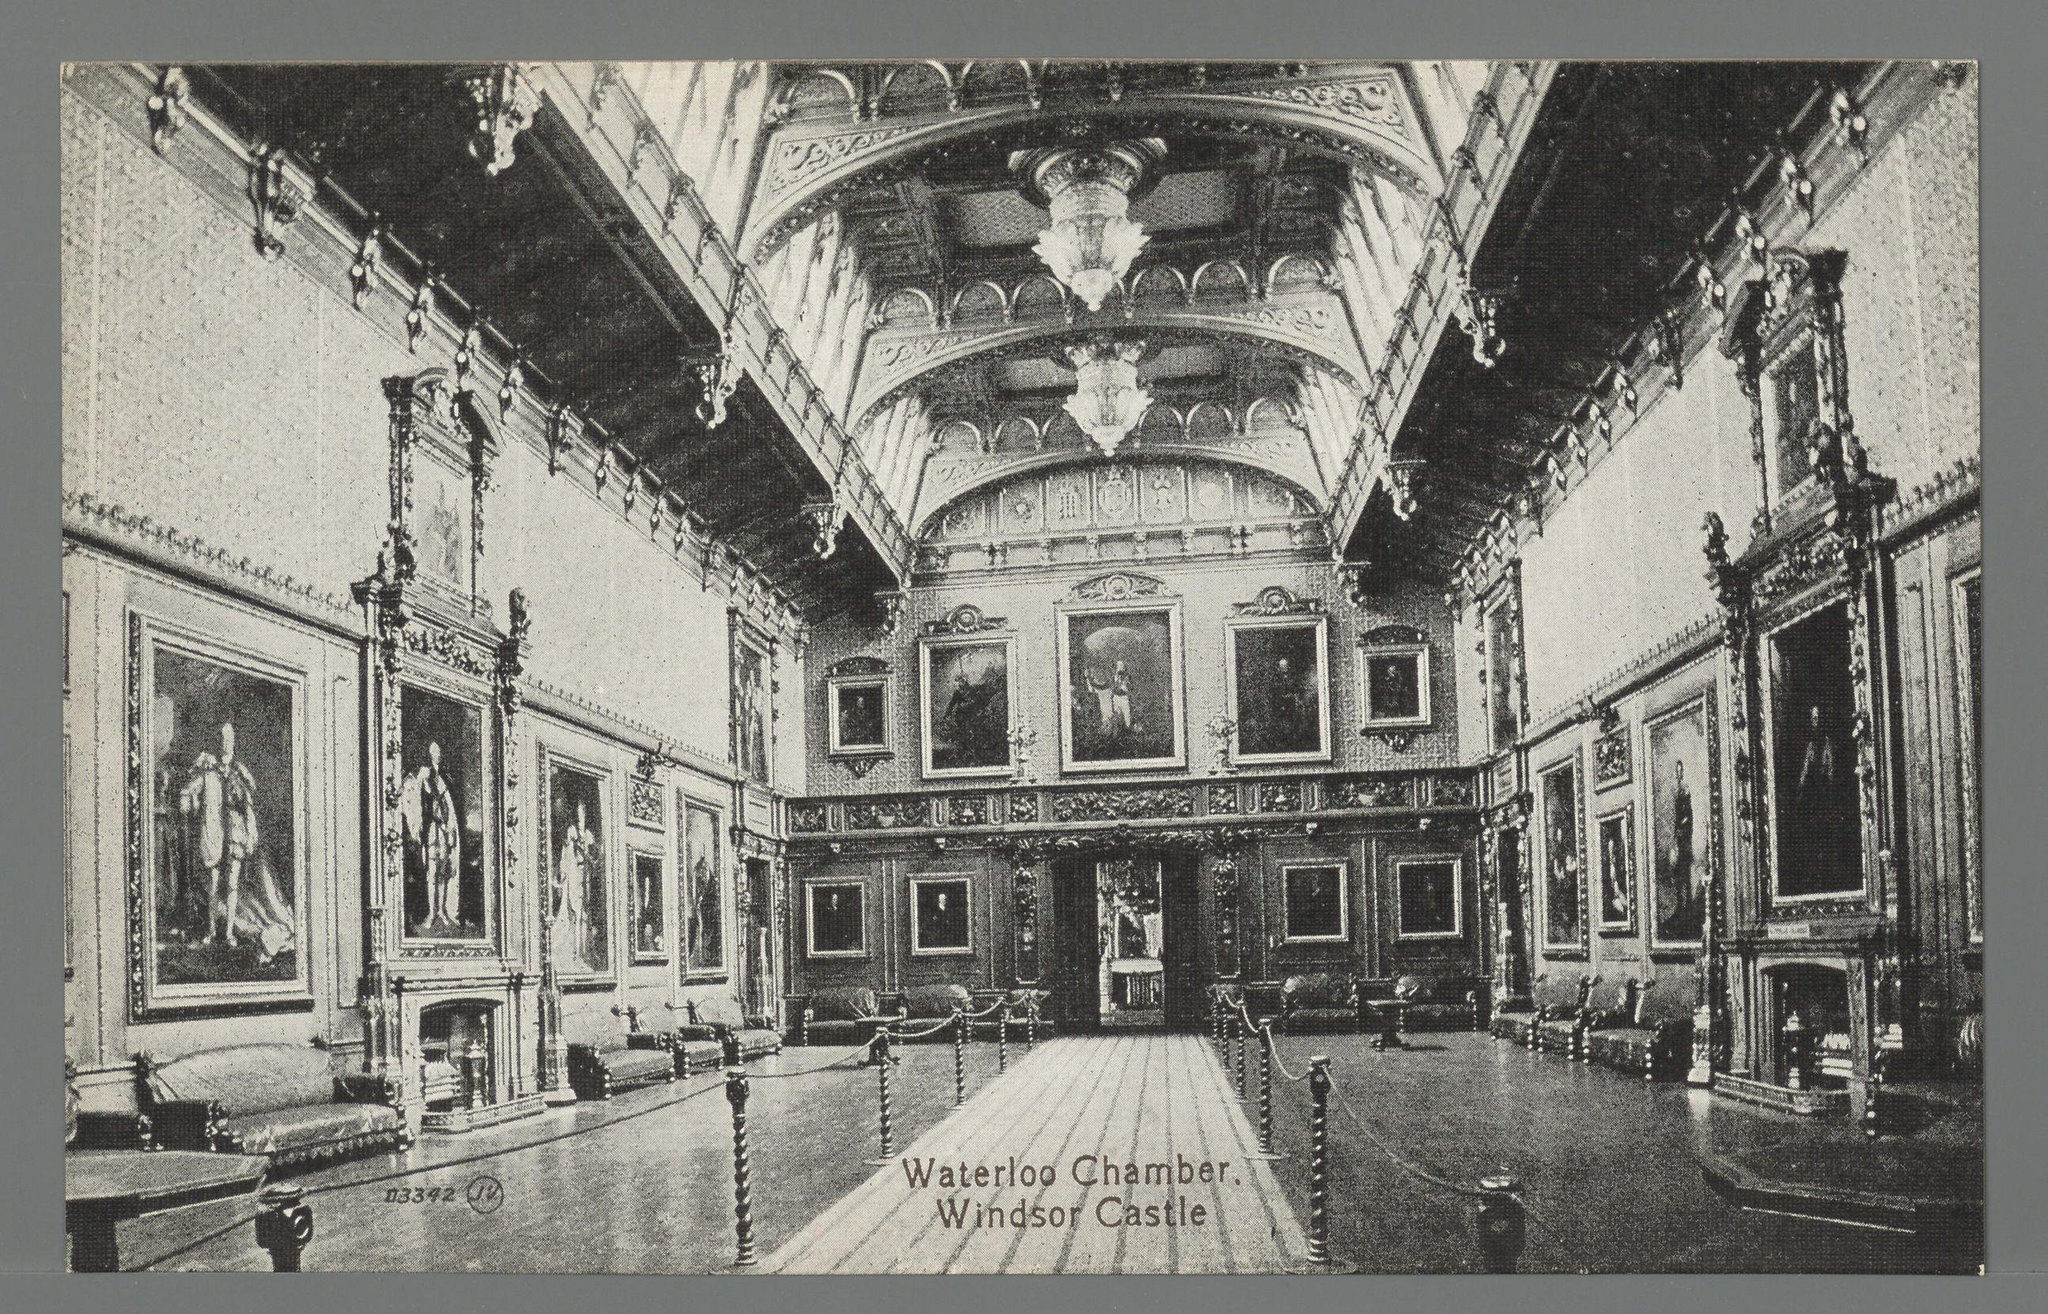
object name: ansichtkaart, prentbriefkaart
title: Waterloo Chamber, Windsor Castle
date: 1902-1930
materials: cardboard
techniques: autotype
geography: windsor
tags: castle, interior of the house